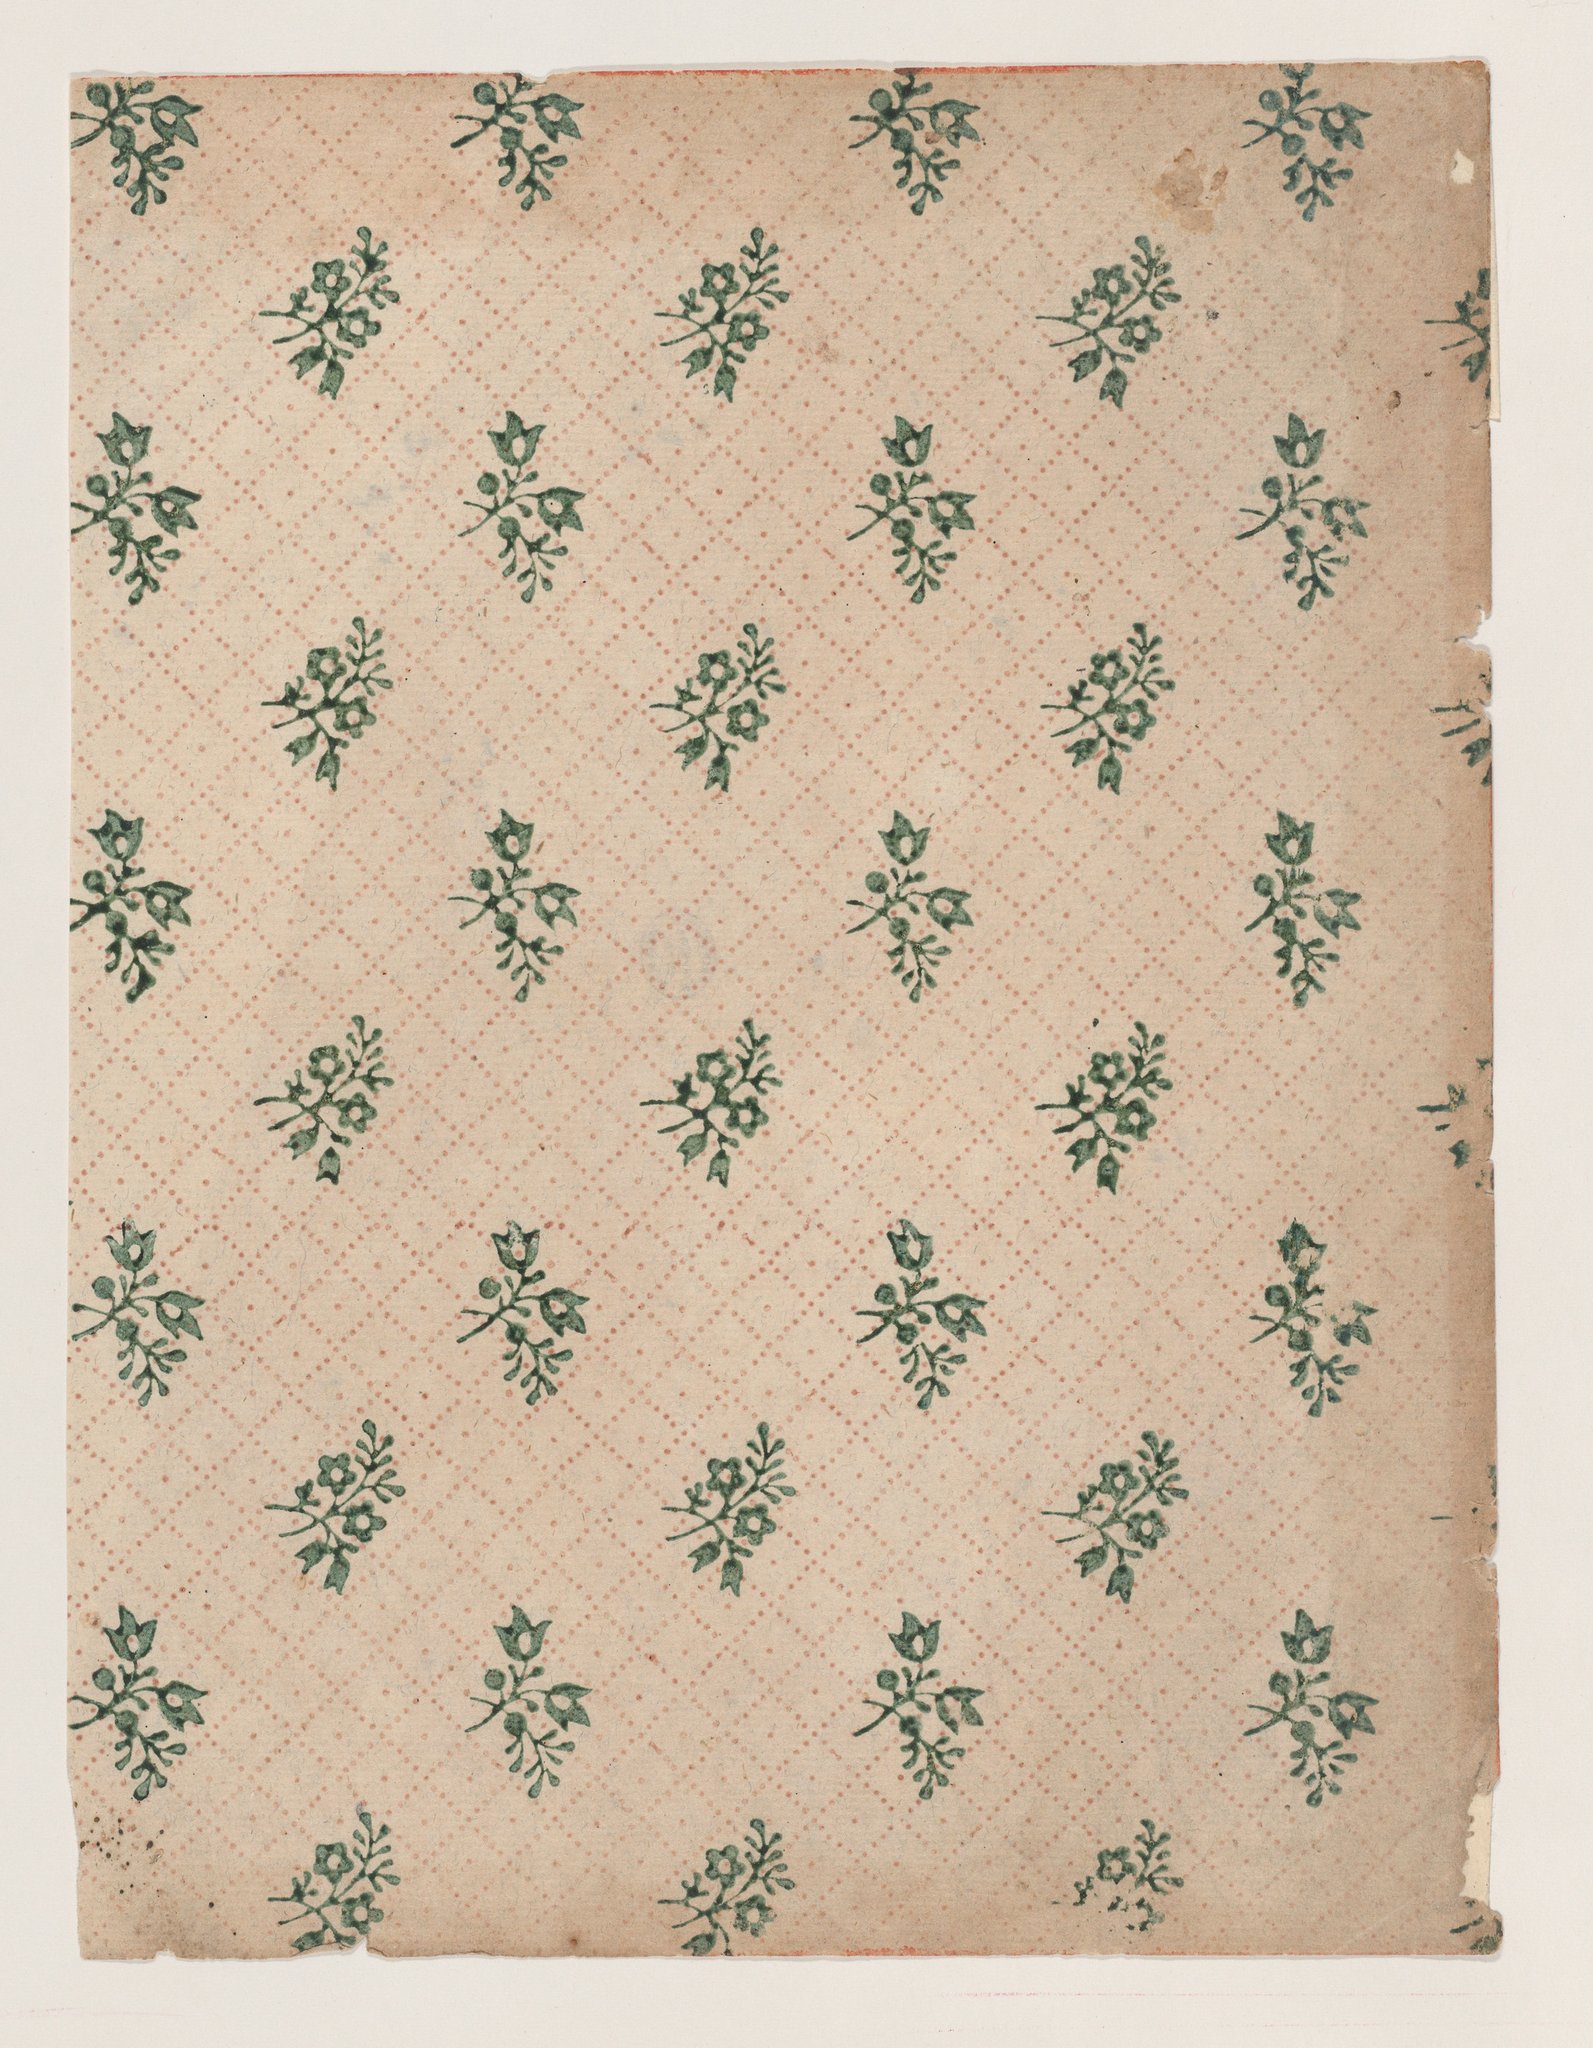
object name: print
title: Sheet with dot grid pattern with bouquets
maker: Anonymous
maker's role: artist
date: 1801-1900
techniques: relief print